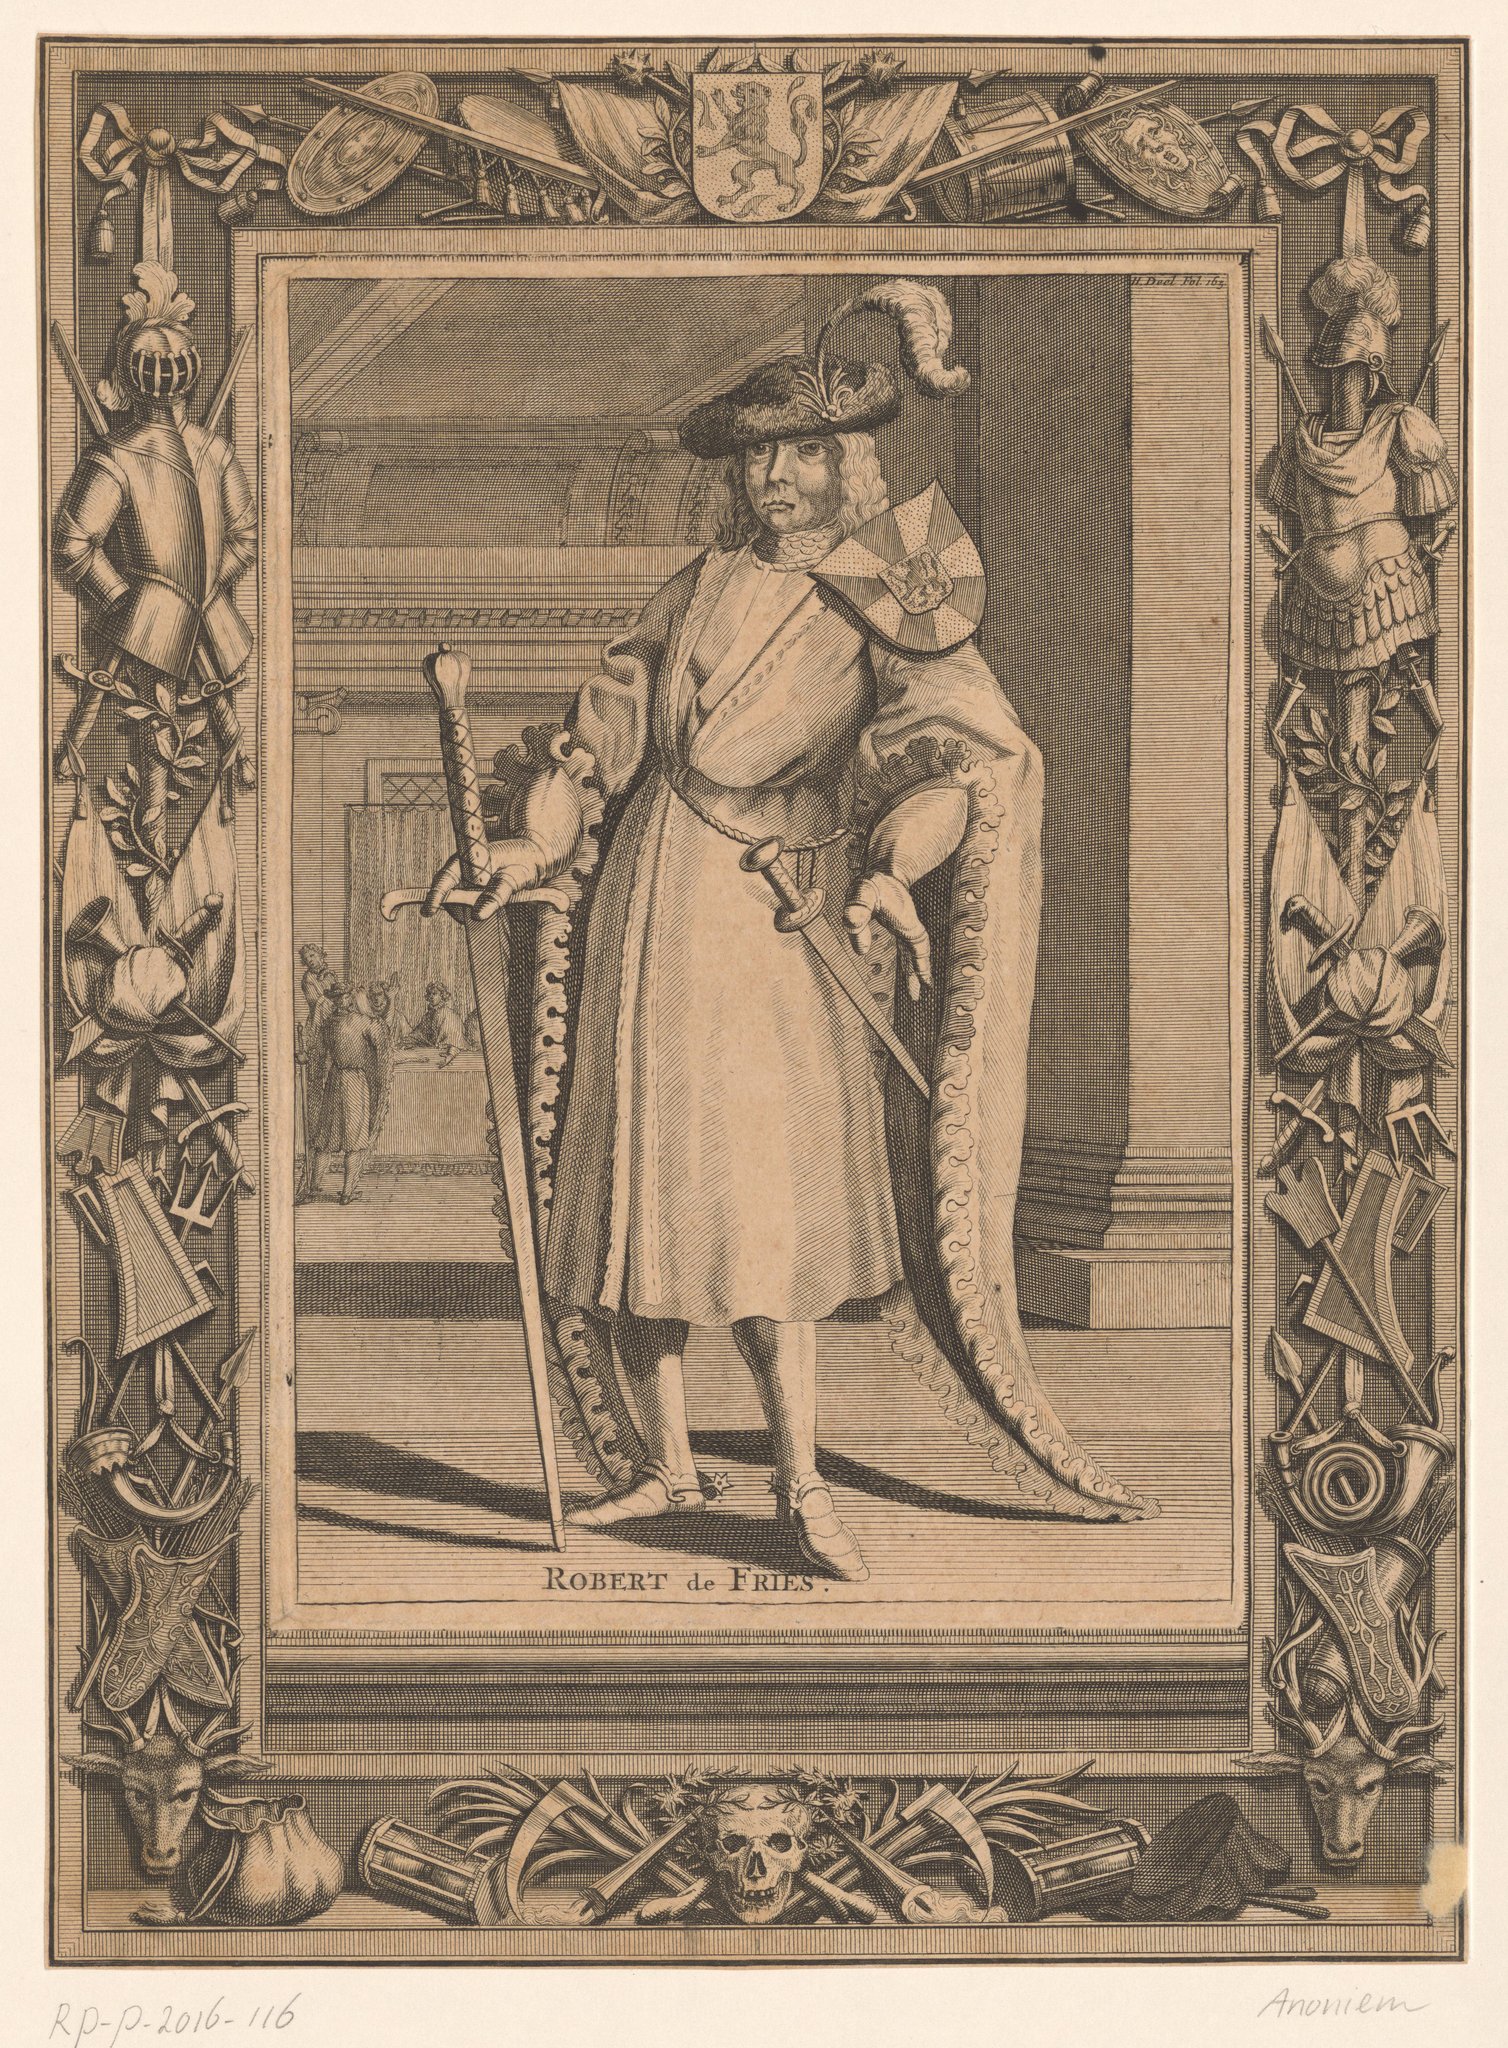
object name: print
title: Portret van Robrecht I de Fries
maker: Anonymous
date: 1725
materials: paper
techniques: engraving, etching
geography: northern netherlands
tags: coat of arms (symbol of sovereignty), historical person (...) - historical person (...) portrayed alone, (human) skull, armour, hacking and thrusting weapons: sword, ruler, sovereign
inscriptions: collector's mark: Lugt 2228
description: Portret van Robrecht de Fries ten voeten uit, met wapenschild op de linkerschouder. Rondom een ornamentele omlijsting met wapentrofeeën.